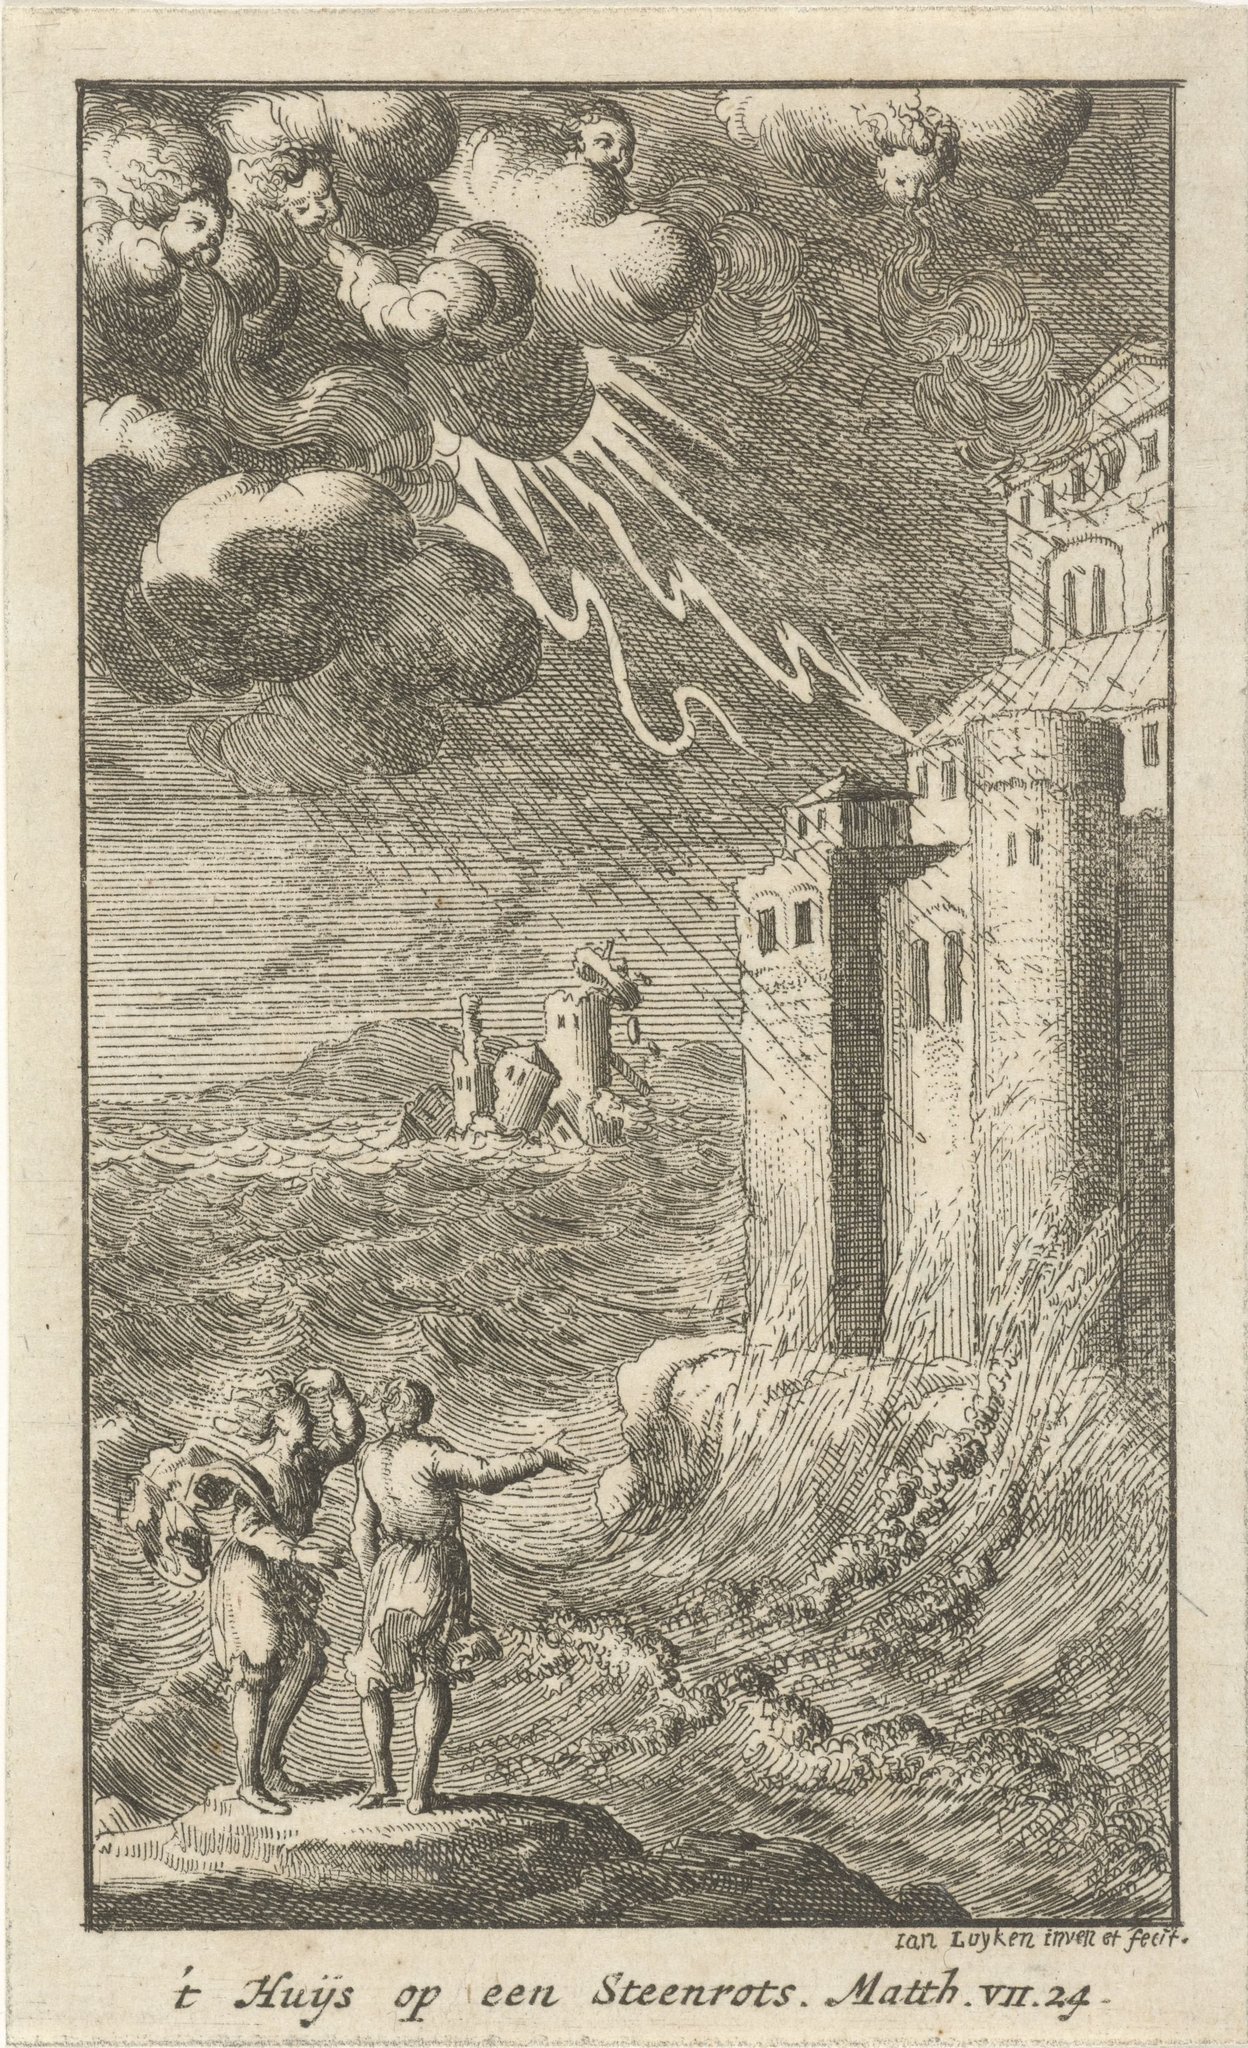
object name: book illustration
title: 't Huijs op een Steenrots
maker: jan luyken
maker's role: draughtsman, print maker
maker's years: 1649-1712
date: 1681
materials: paper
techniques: etching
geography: amsterdam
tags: house built upon a rock; house built upon sand ~ doctrine of christ on love, etc. (matthew 7:24-27; luke 6:47-49)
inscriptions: collector's mark: Lugt 2228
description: Twintig prenten van deze serie (waaronder de hier besproken prent) verschenen mogelijk voor het eerst in: Het Nieuwe Testament ofte alle Boecken des Nieuwen Verbondts onses Heeren Iesu Christi. Amsterdam: Hieronymus Sweerts, Jan ten Hoorn, Jan Bouman en Daniel van den Dalen, 1681. De complete vierentwintigdelige serie prenten is opgenomen in: Het Nieuwe Testament ofte alle Boecken des Nieuwen Verbondts onses Heeren Iesu Christi. Dordrecht: Pieter en Jacob Keur, 172X (niet voor 1727). De prenten werden, hetzij alle tezamen, hetzij gedeeltelijk, veel gebruikt tot versiering van Nieuwe Testamenten en verschenen tevens in kopie.